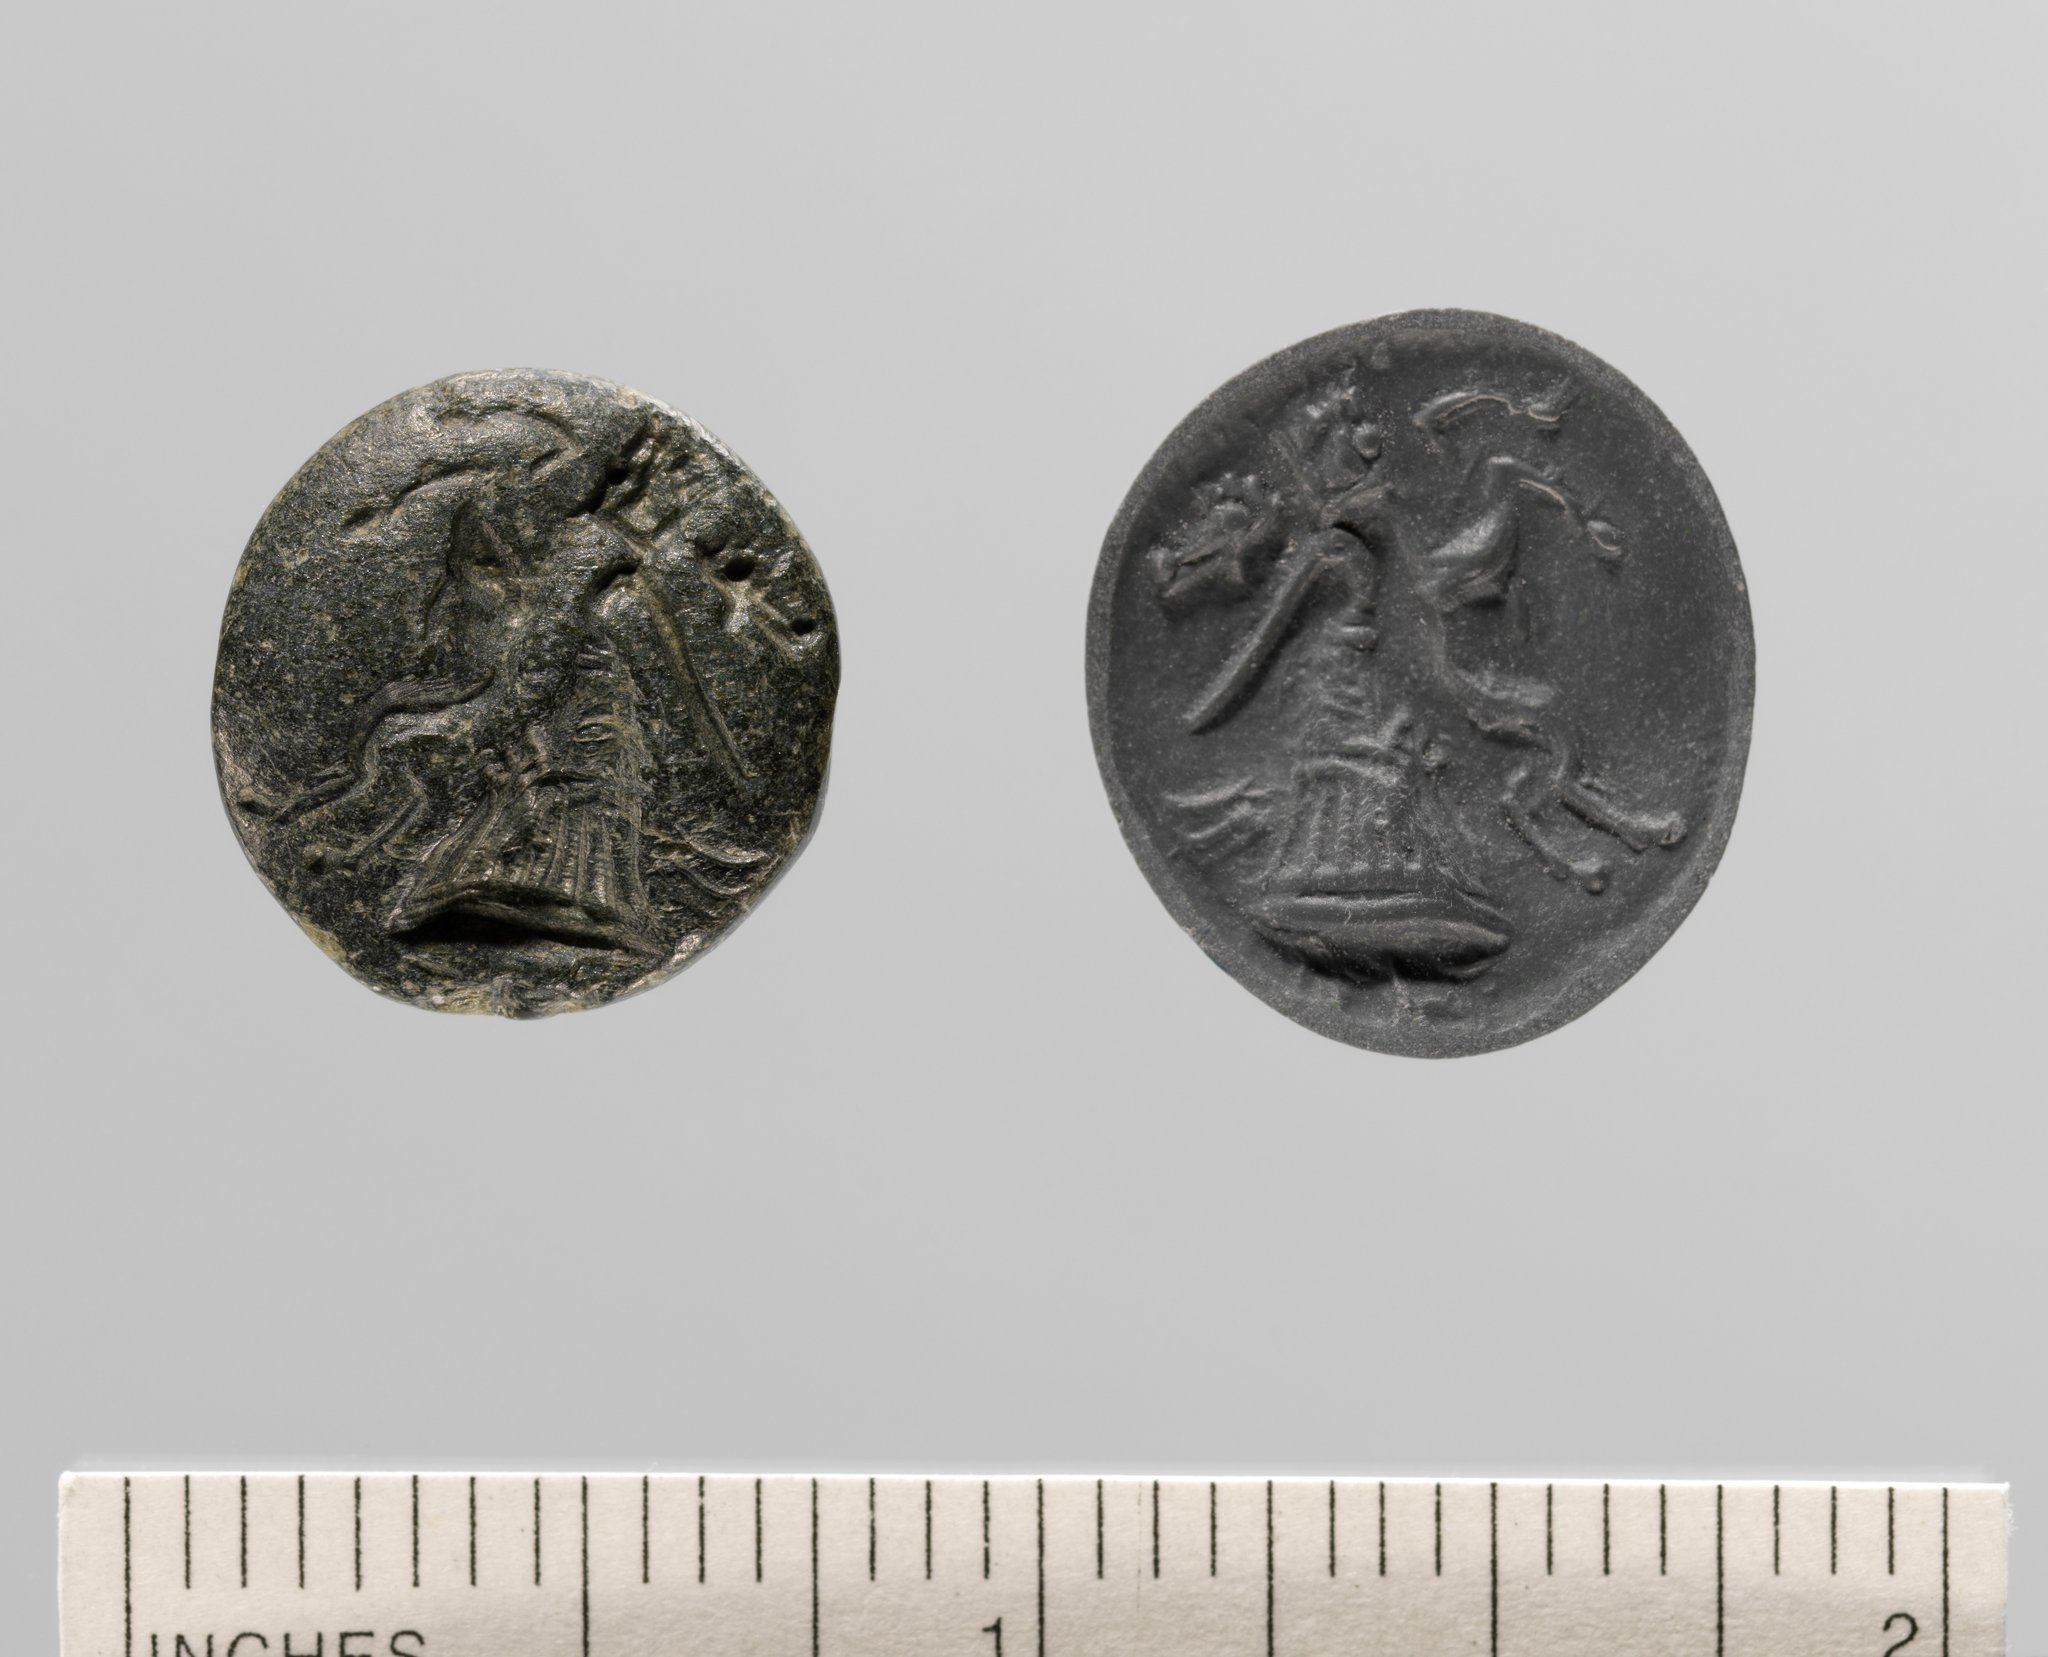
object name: seal, lentoid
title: Serpentine Lentoid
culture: minoan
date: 1525-1450 BCE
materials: stone